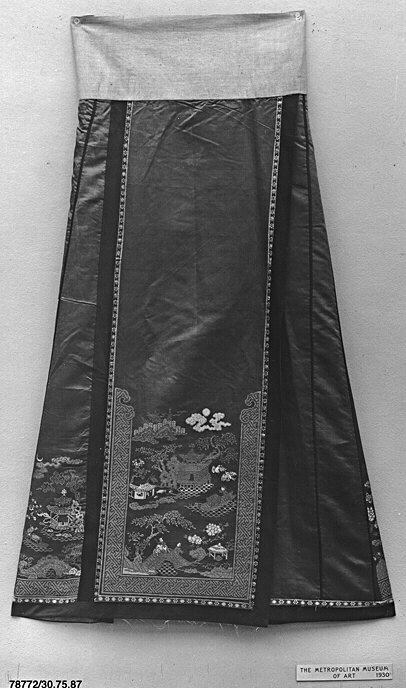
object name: skirt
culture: chinese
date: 1801-1900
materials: gold, silk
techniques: brocade